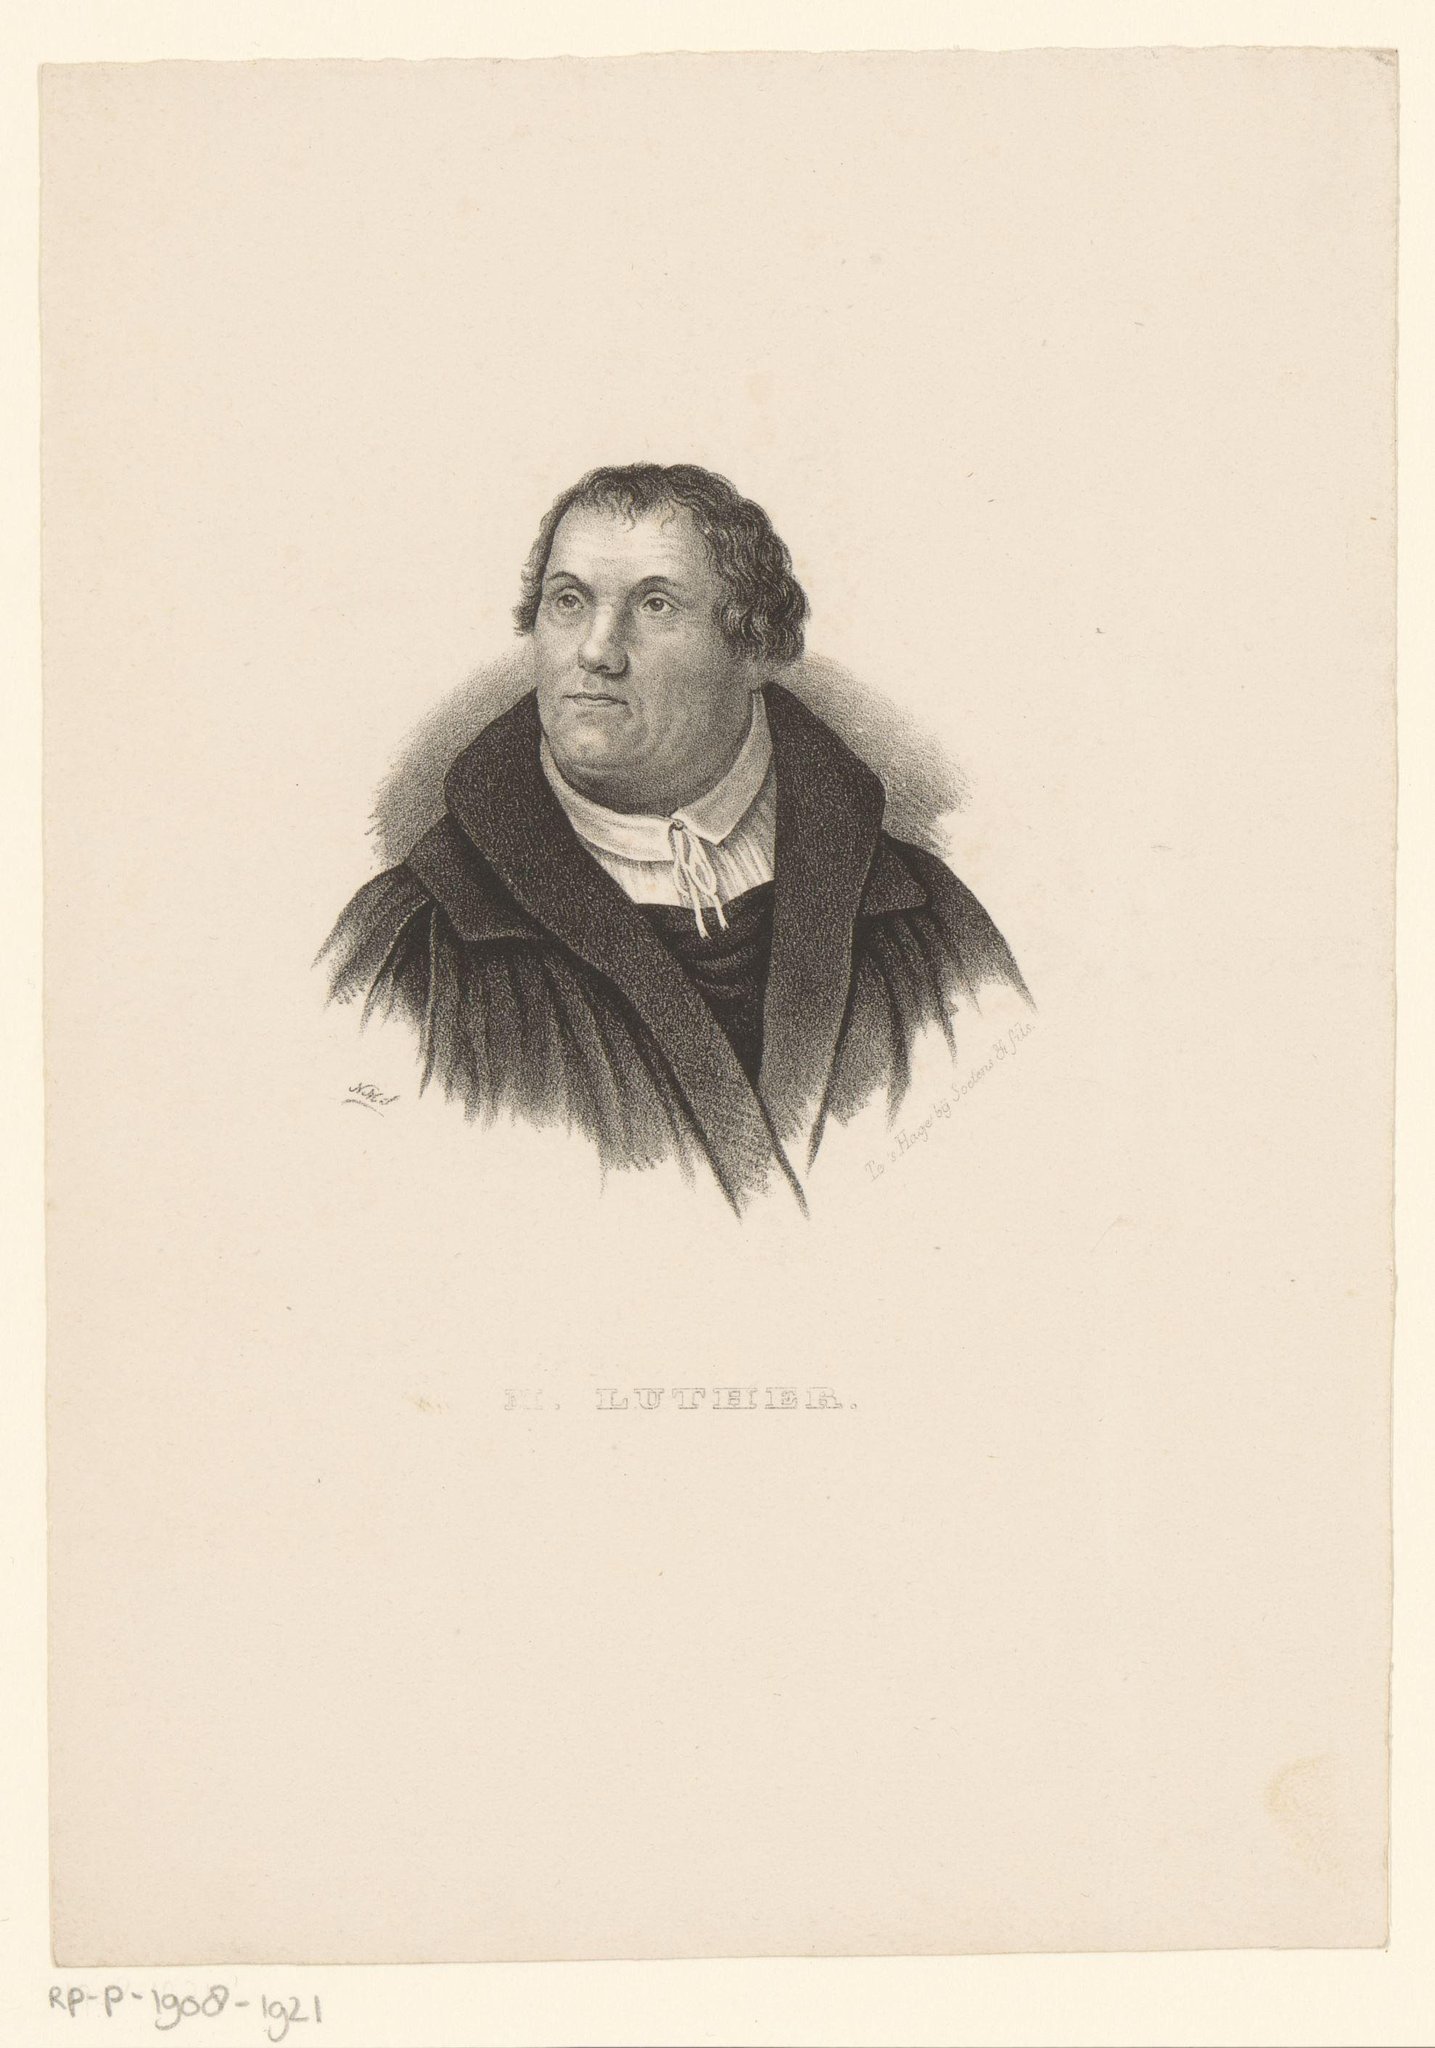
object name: print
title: Portret van Maarten Luther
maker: nicolaas martinus schild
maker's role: draughtsman, print maker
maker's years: 1822-1840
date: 1837-1840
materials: paper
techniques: lithograph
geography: the hague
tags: priest, martin luther, historical persons (+ (full) bust portrait)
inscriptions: collector's mark: Lugt 2228